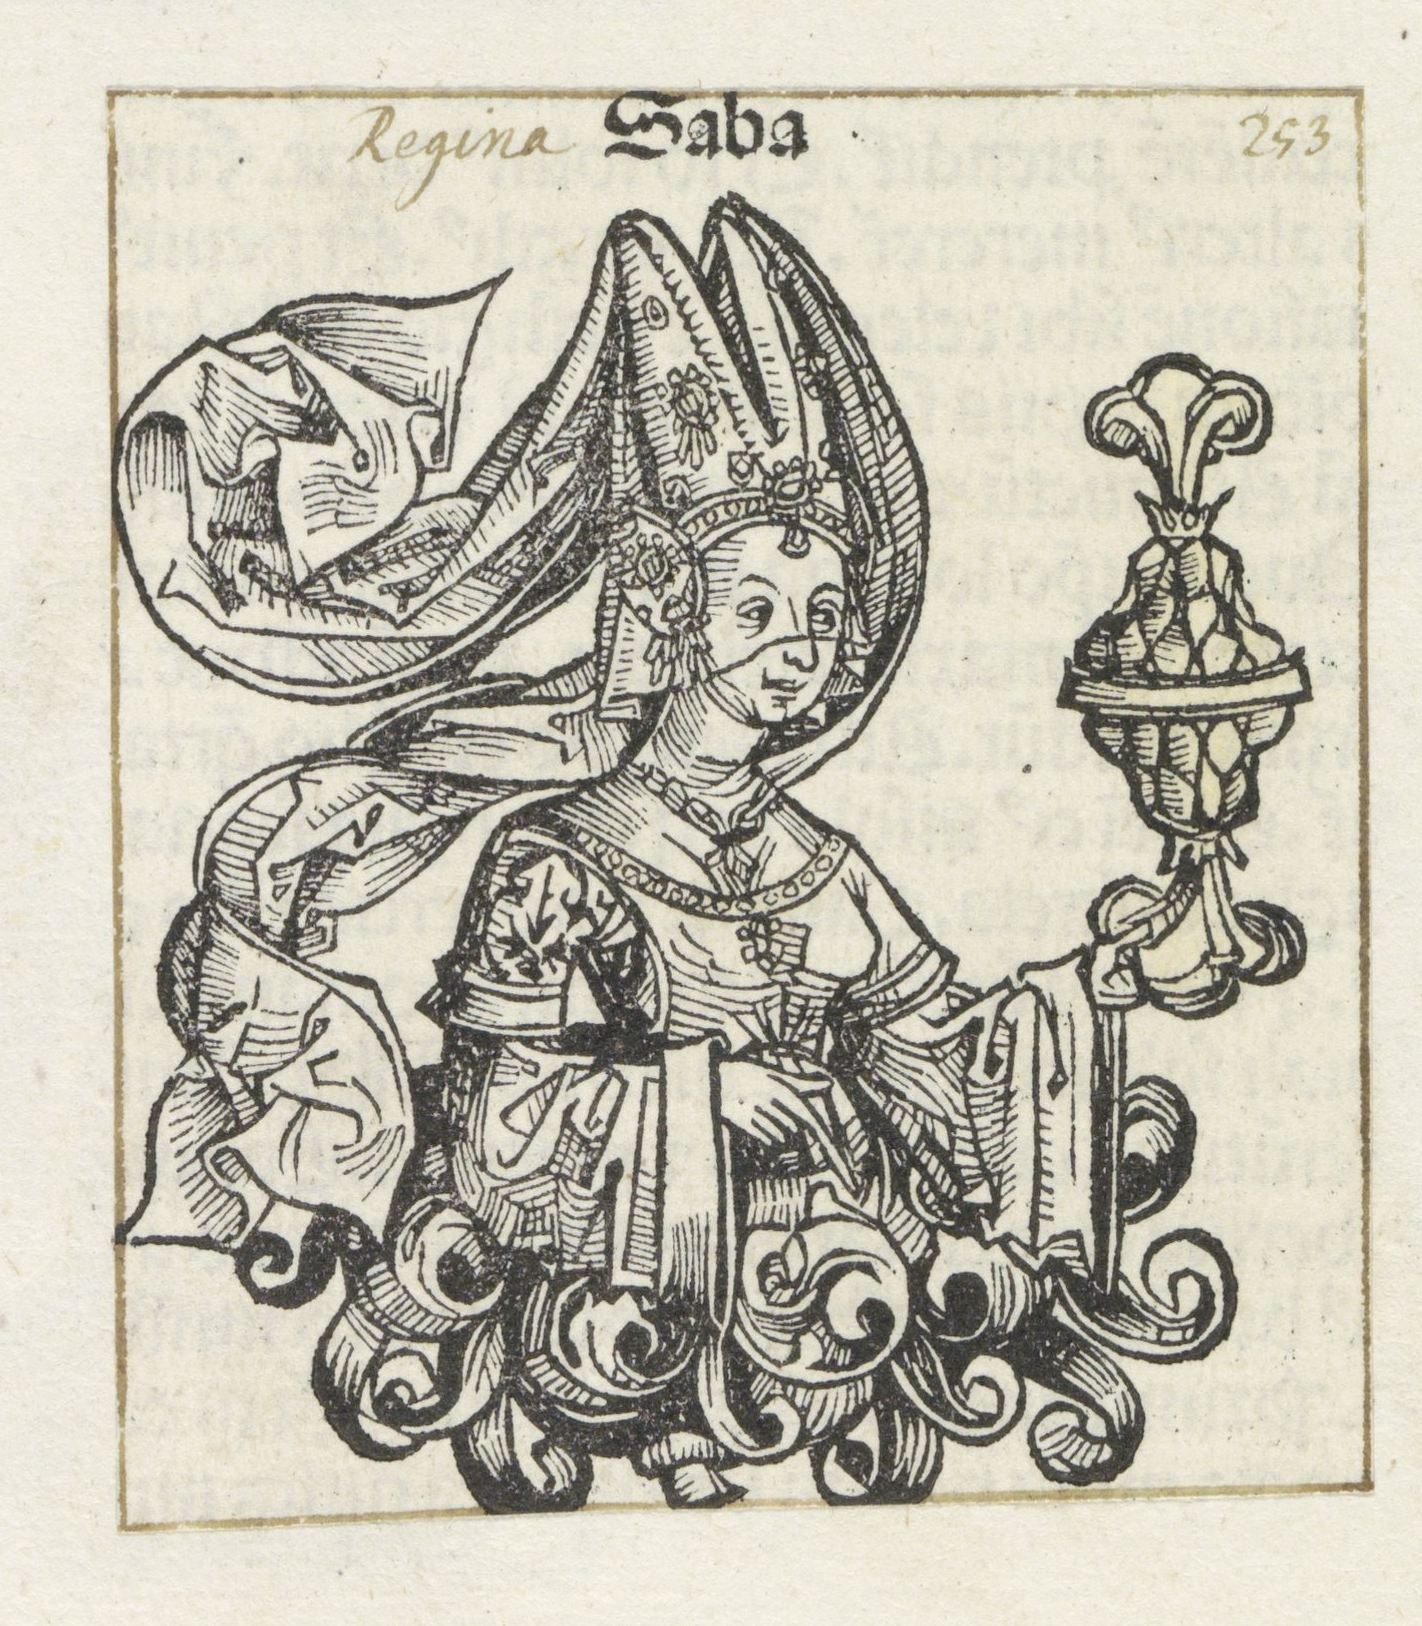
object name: album leaf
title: Liber Chronicarum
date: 1493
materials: paper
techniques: letterpress printing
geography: nuremberg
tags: persons from the old testament (not in biblical context, nor occurring in legendary/historical extensions included in division 71)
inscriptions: inscription: ‘253’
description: Een bloemkelk met een edelvrouw, naar rechts gekeerd. Ze heeft een stuk kostbaar vaatwerk in haar linkerhand. De tekst identificeert haar als de koningin van Seba. De prent maakt deel uit van een album.